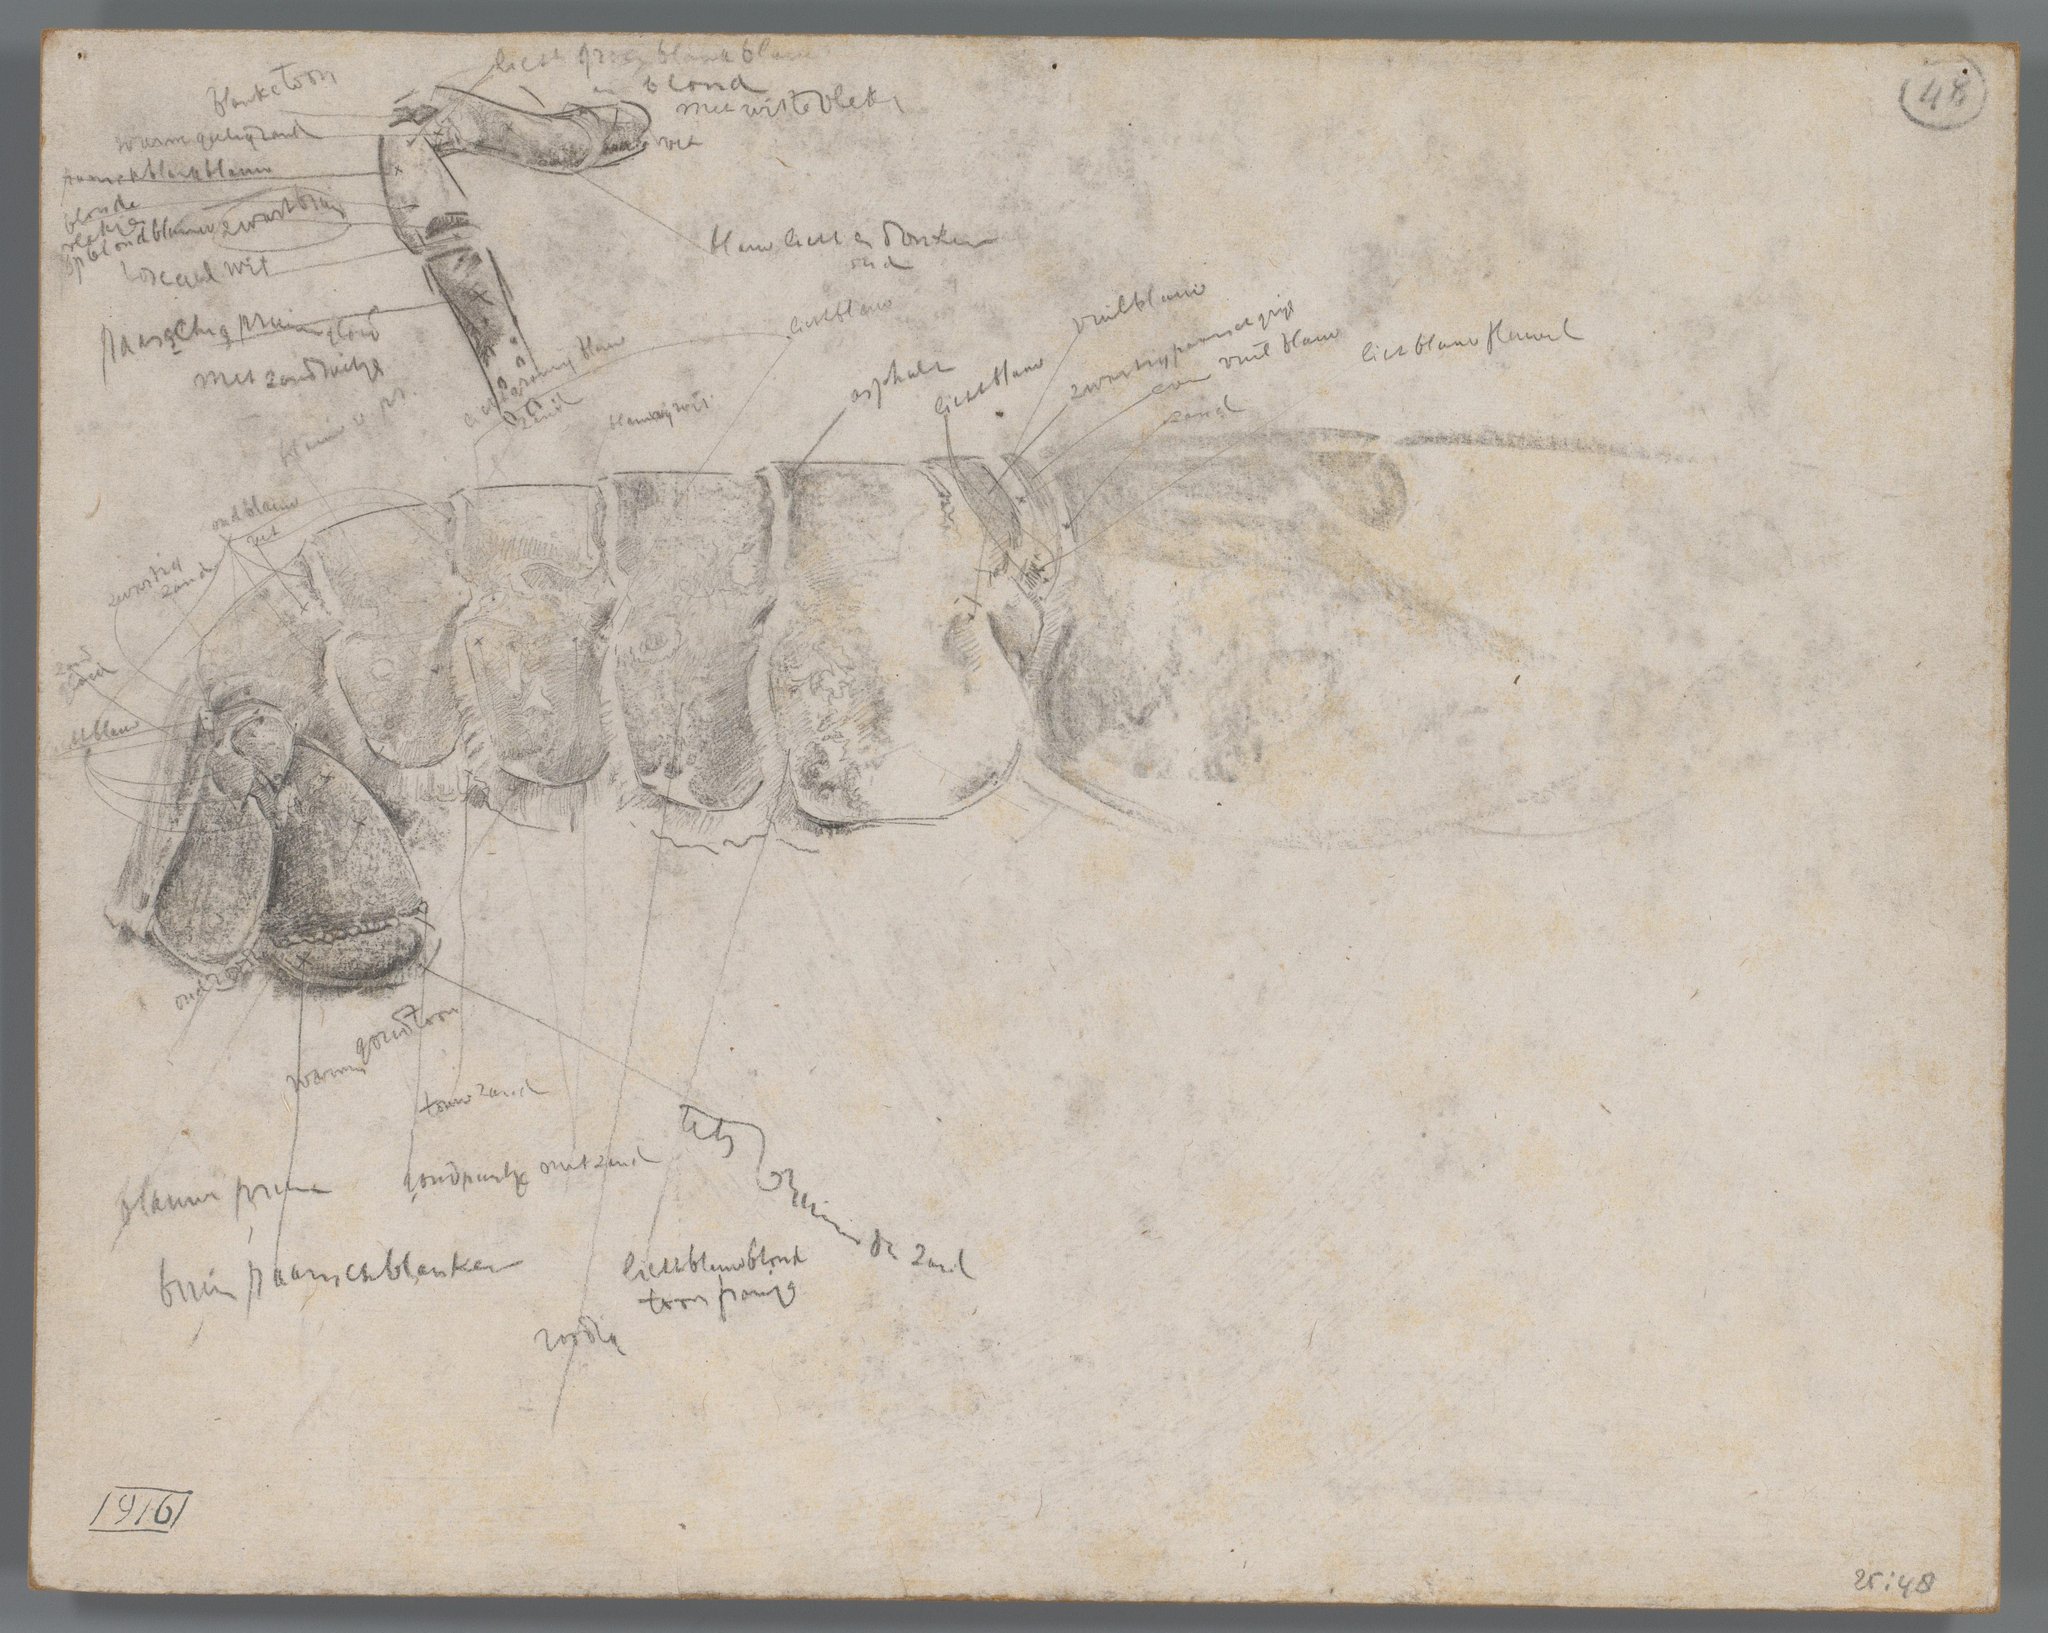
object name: drawing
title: Studie van het achterlijf van een kreeft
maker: gerrit willem dijsselhof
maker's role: designer, draughtsman, print maker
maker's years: 1866-1924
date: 1876-1924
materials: cardboard, chalk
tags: crustaceans: lobster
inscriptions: number: ‘48’, number: ‘916’